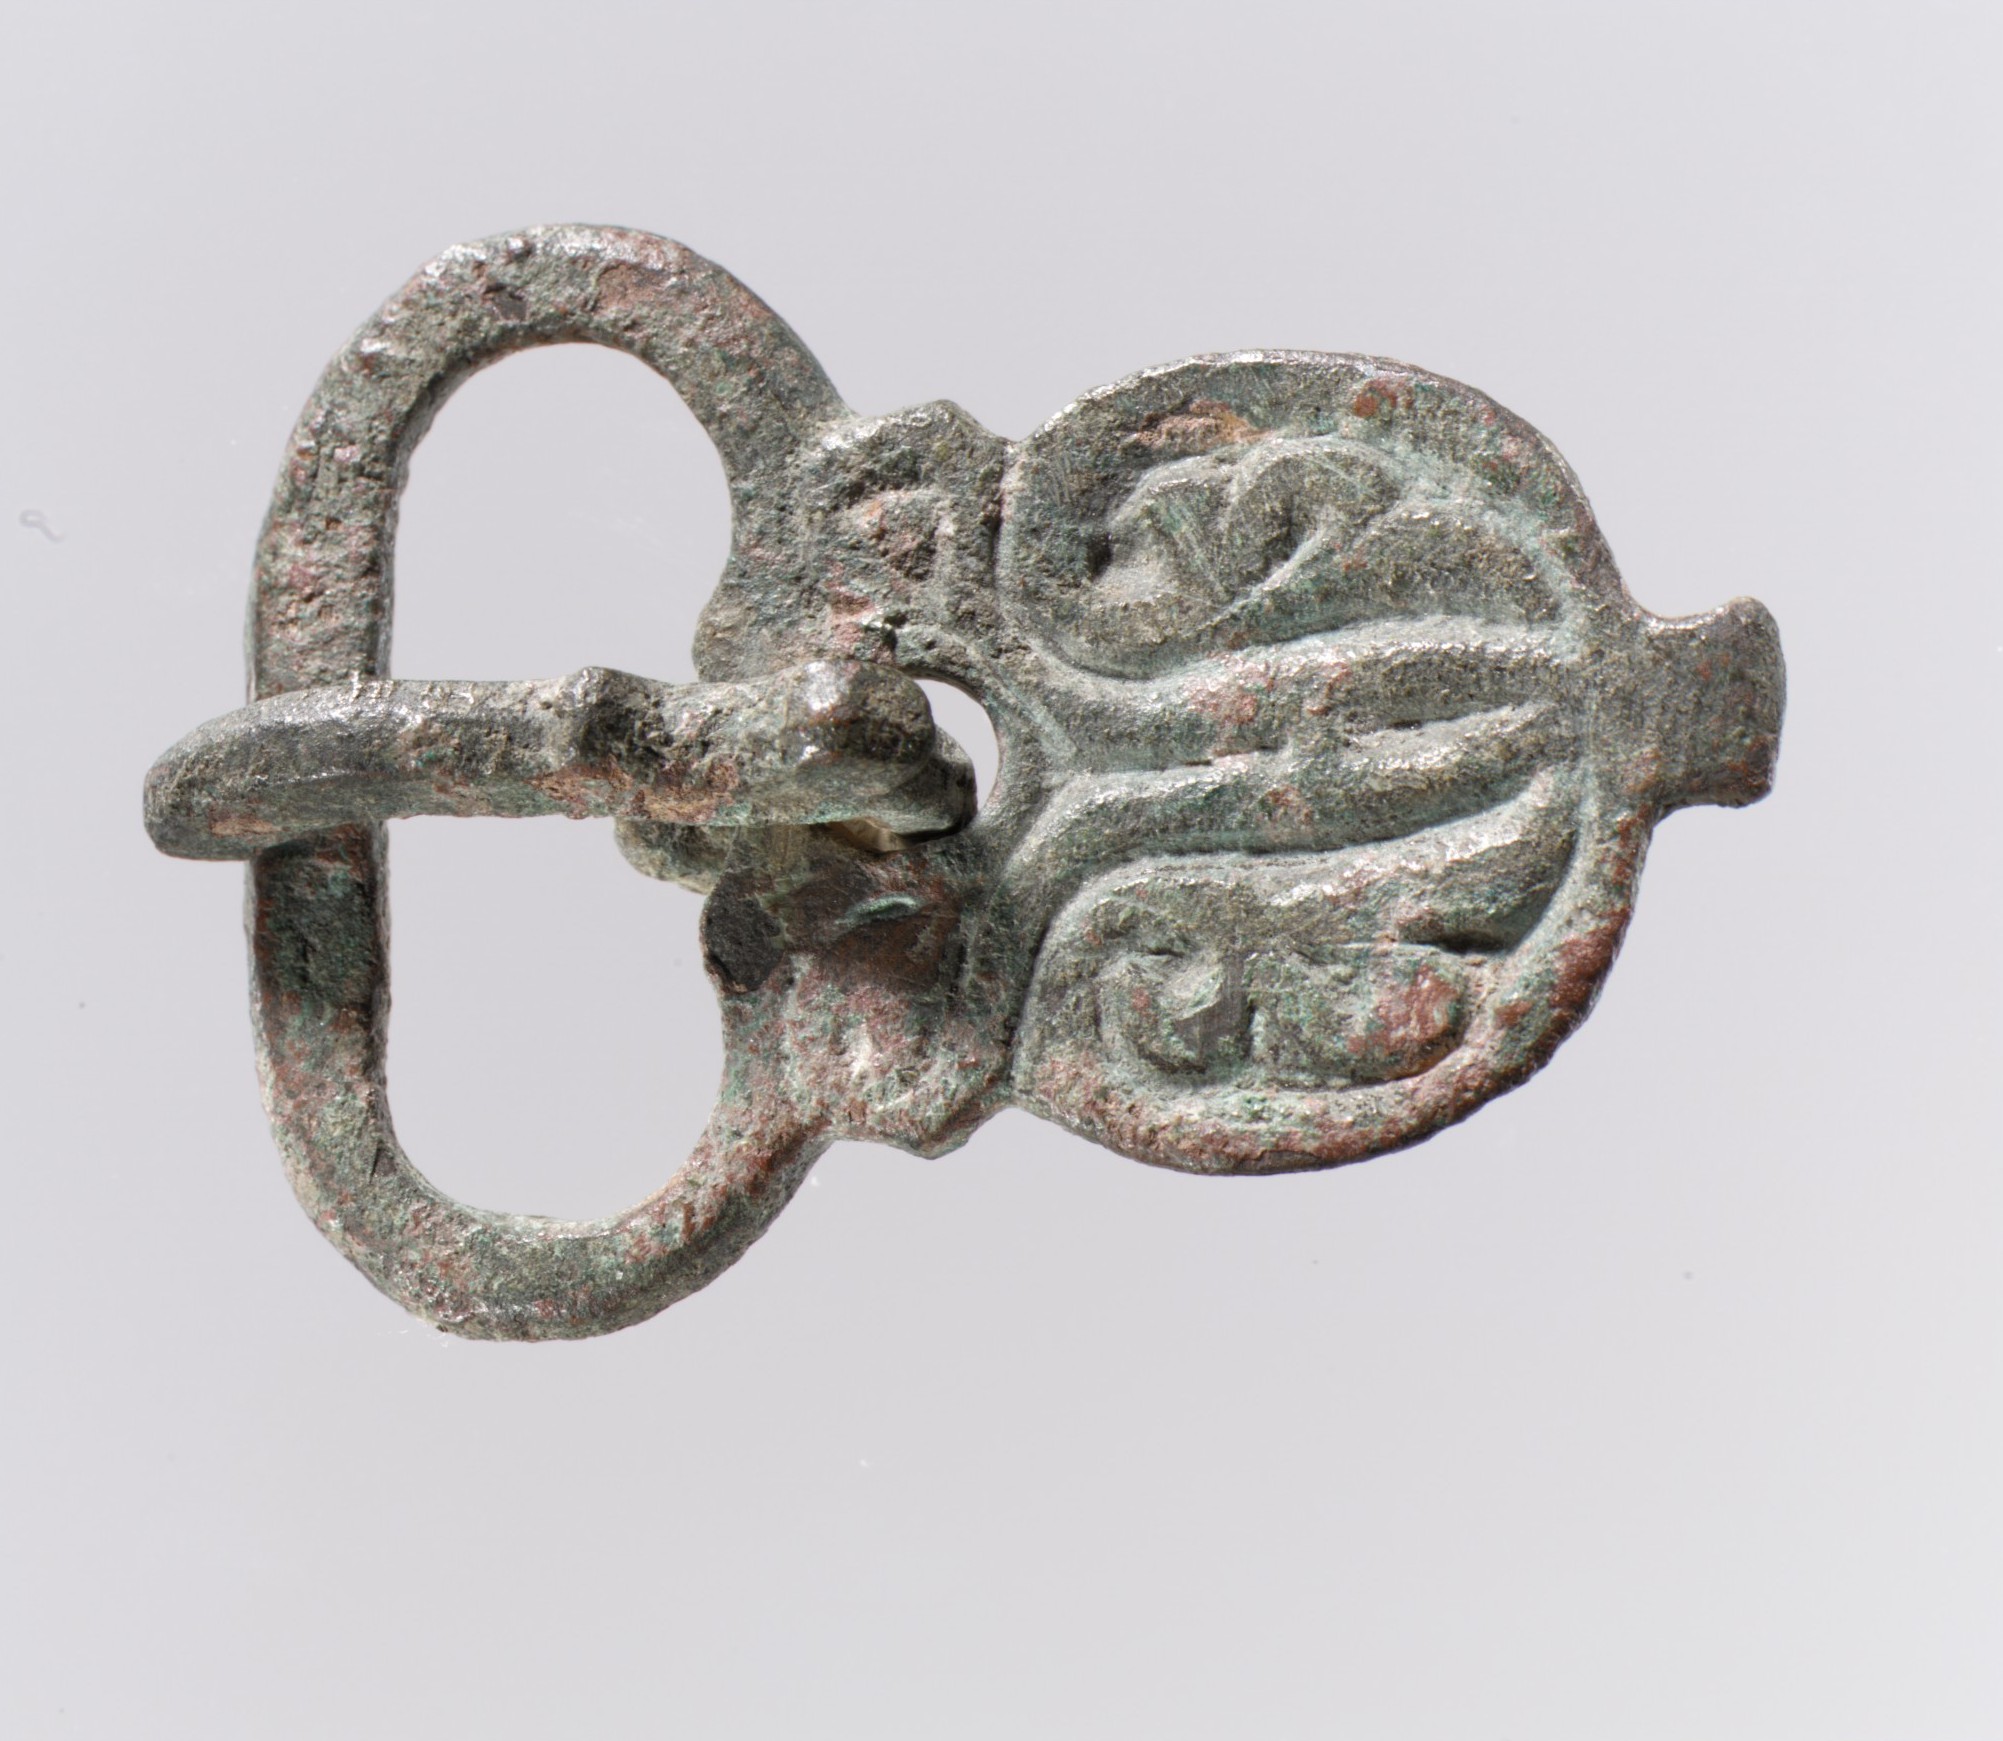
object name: buckle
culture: byzantine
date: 501-700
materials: copper alloy